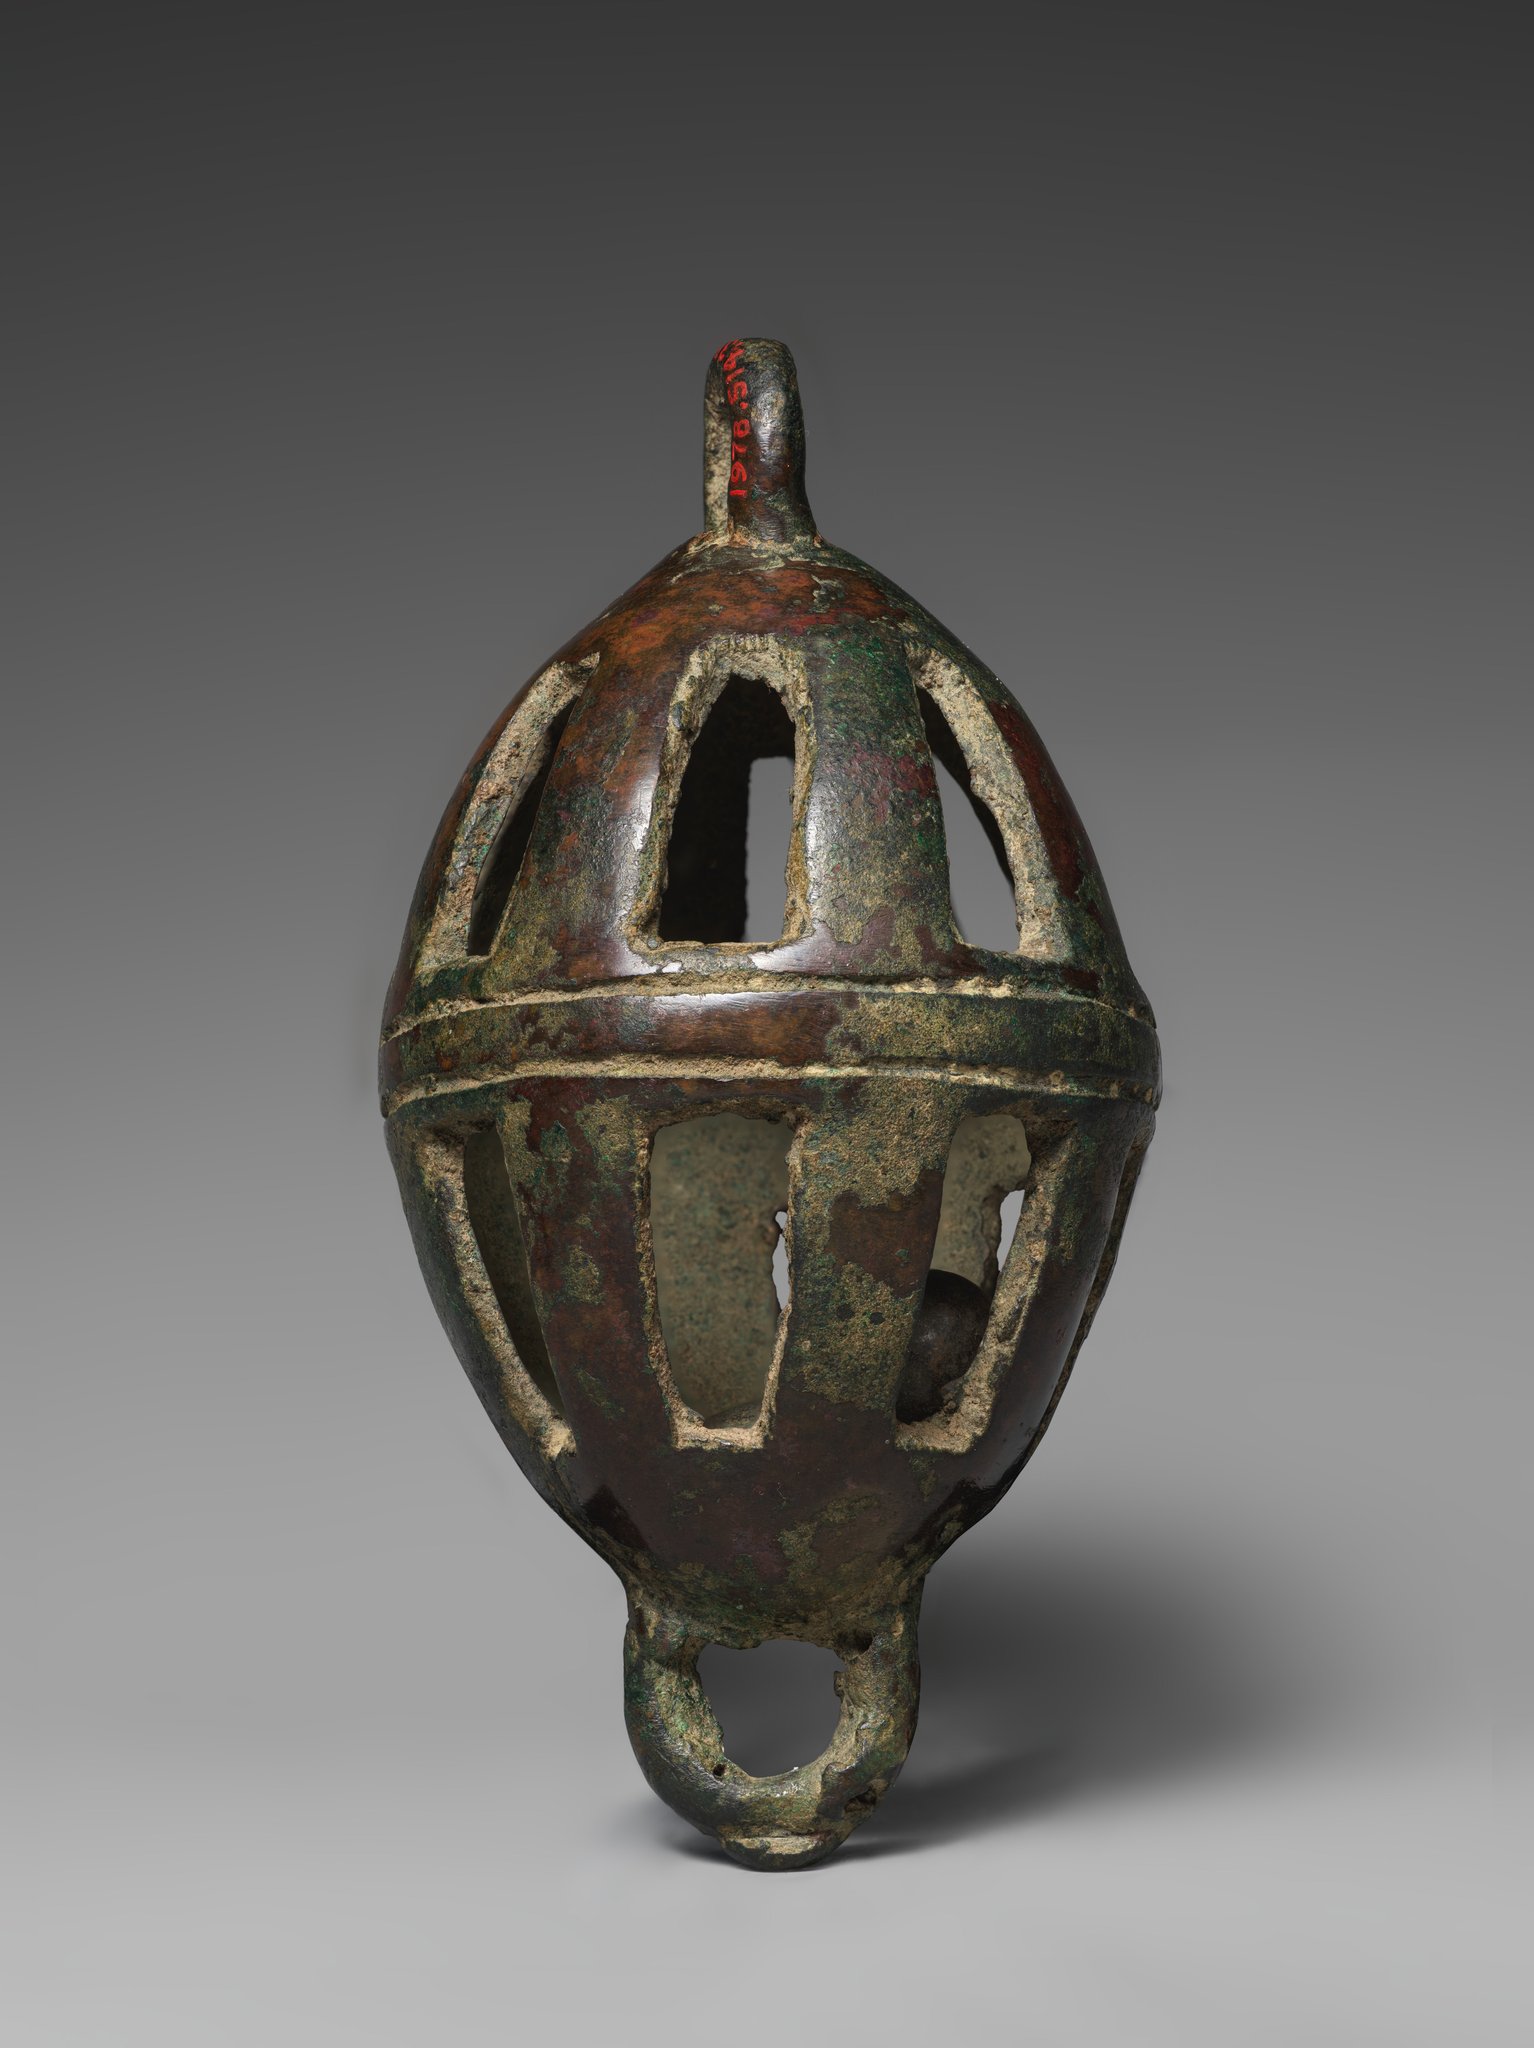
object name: rattle bell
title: Openwork rattle bell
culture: iranian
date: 1000-1 BCE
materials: bronze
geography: iran